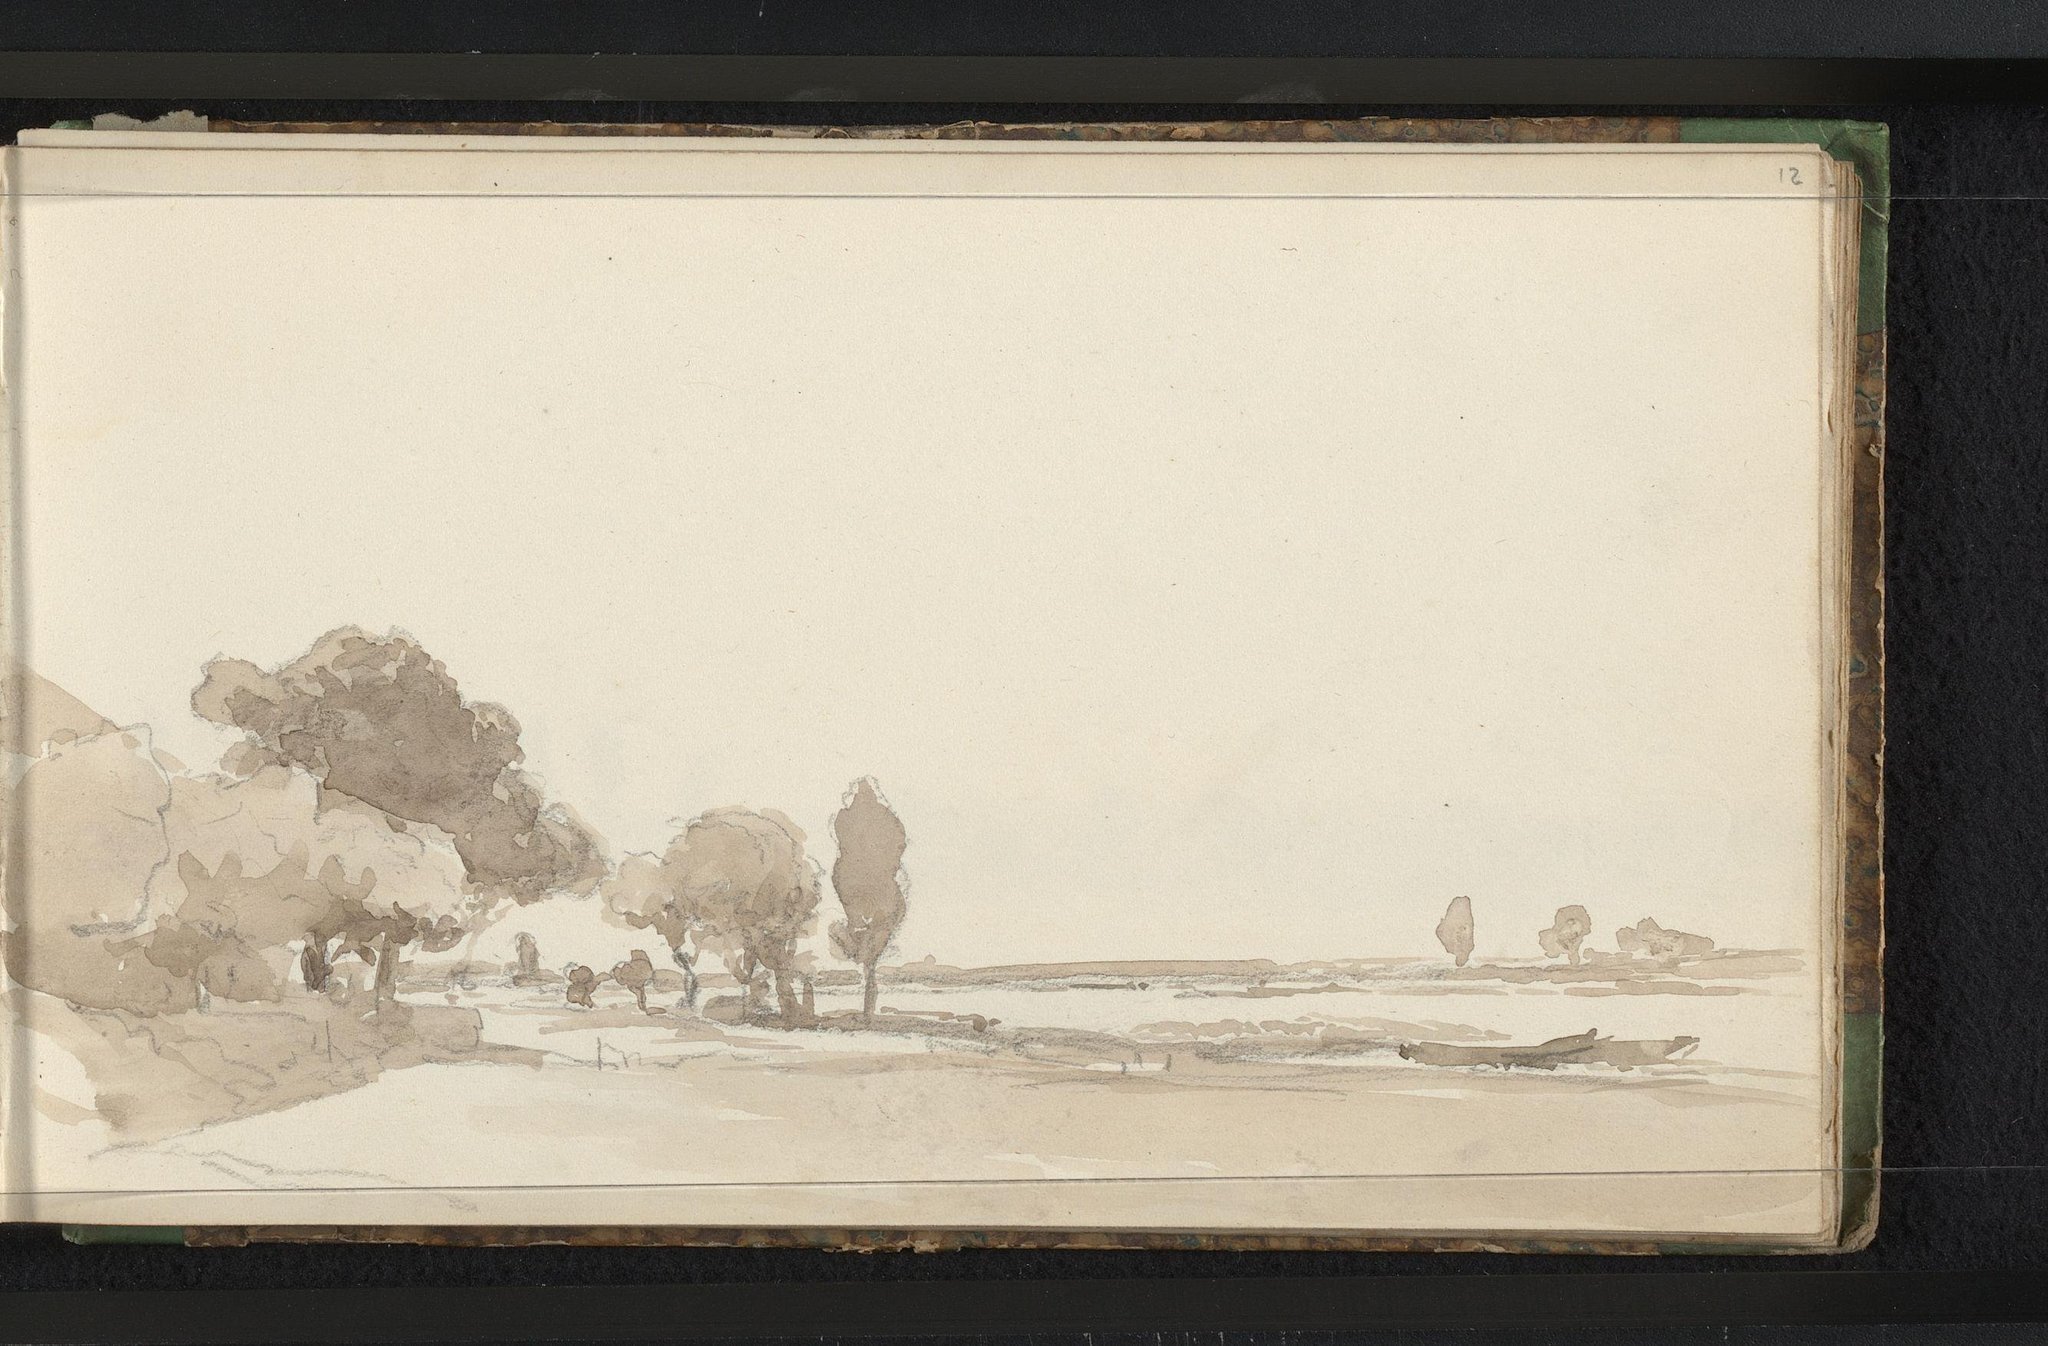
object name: sketchbook leaf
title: Landschap met water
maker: jan bedijs tom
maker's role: draughtsman, painter, print maker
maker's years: 1813-1894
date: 1828-1894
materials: paper, pencil, watercolor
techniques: brush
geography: the hague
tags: trees, landscapes, landscapes with waters, waterscapes, seascapes (in the temperate zone), artist (in general) making preliminary designs, sketching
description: Pagina 12 recto uit een schetsboek met 50 bladen.